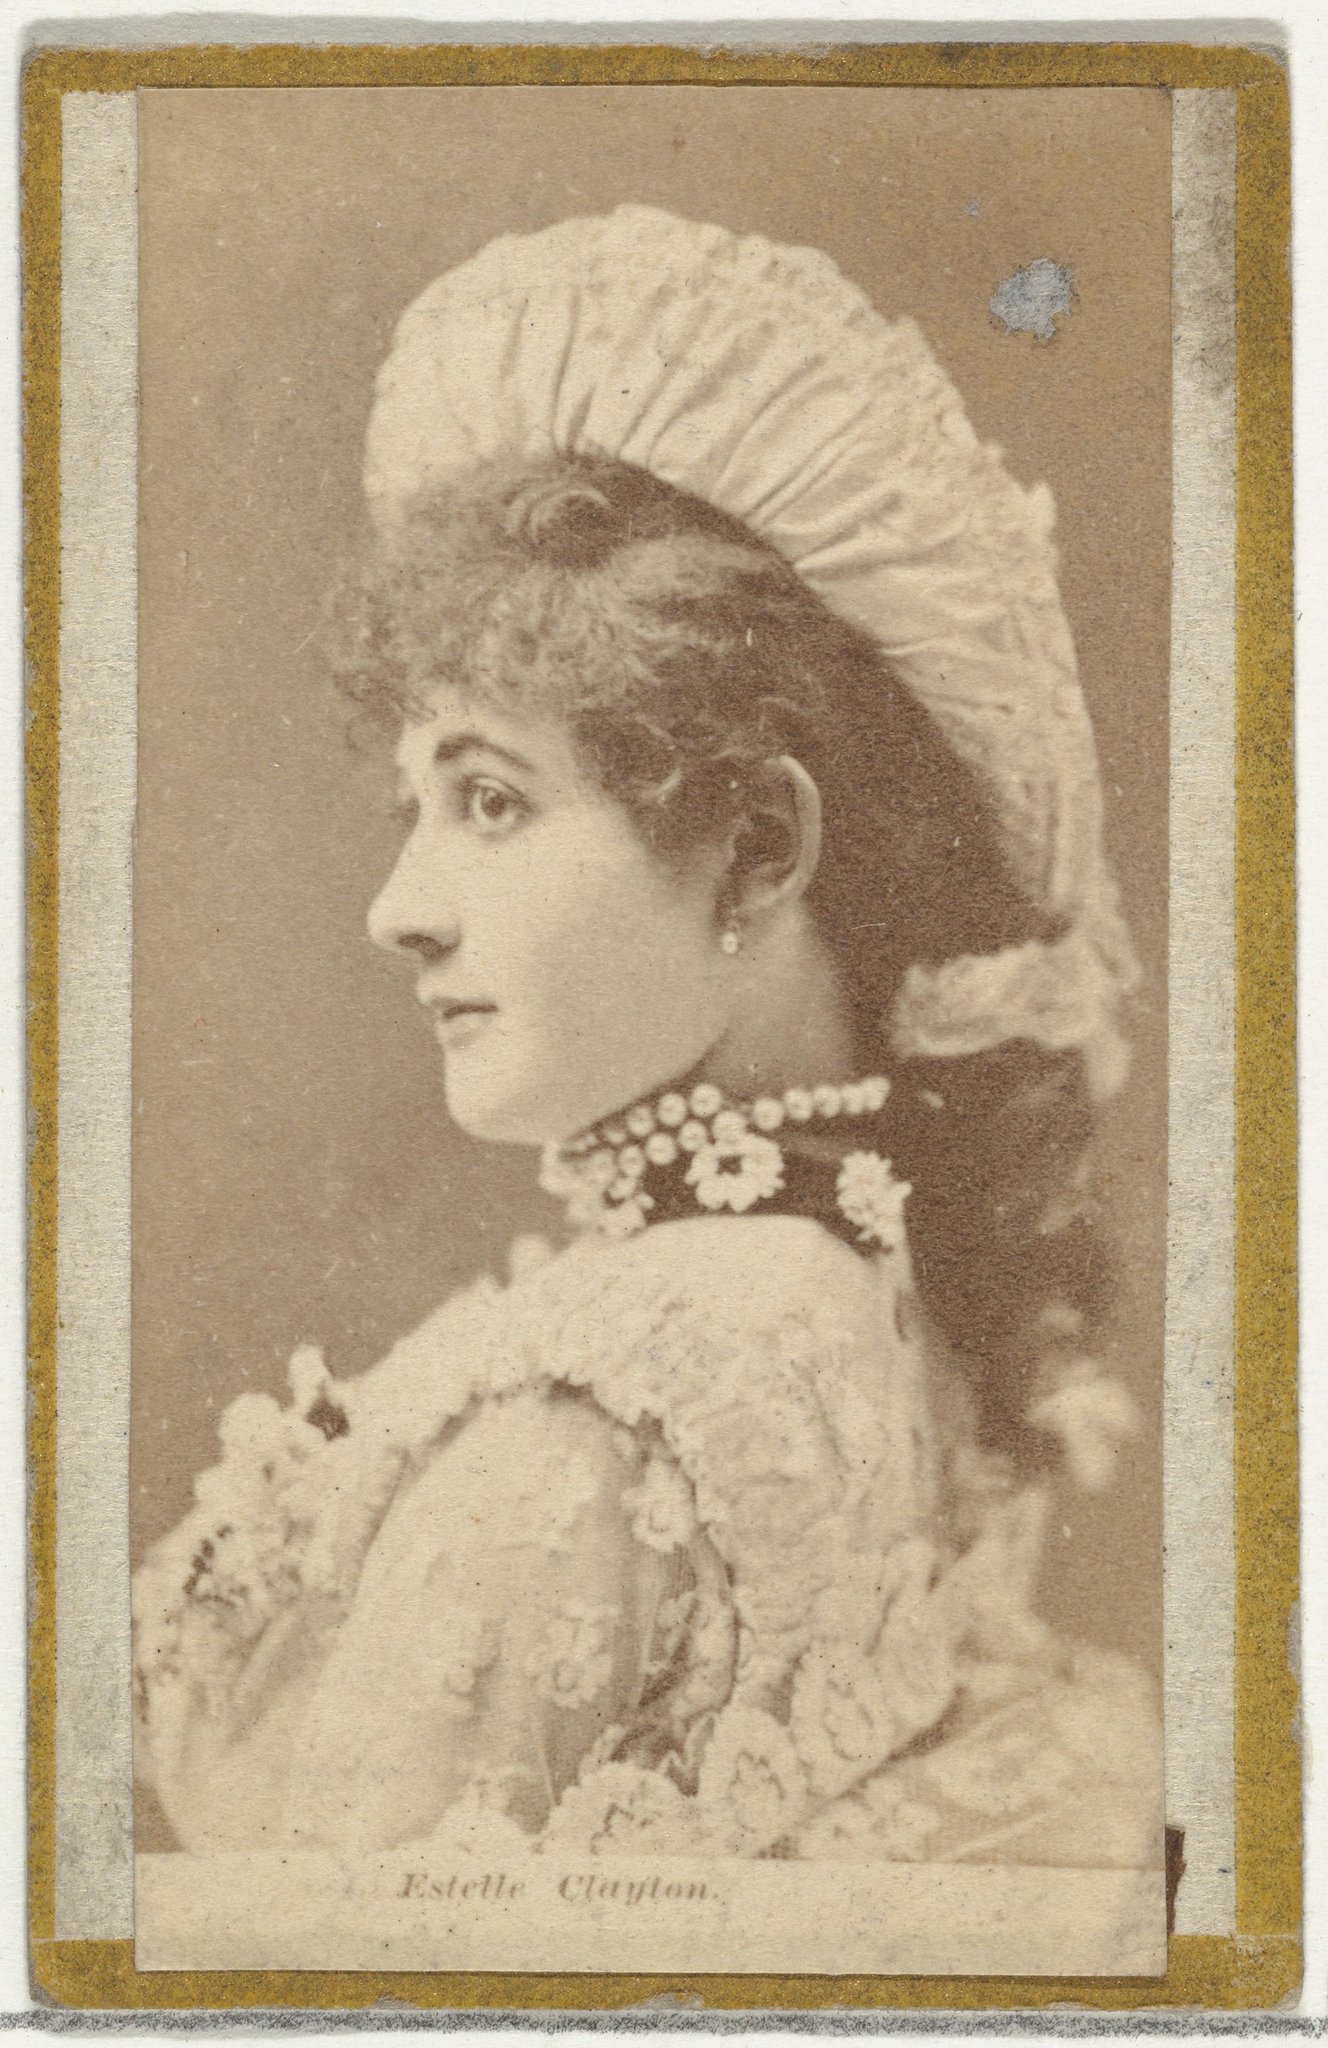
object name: photograph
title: Estelle Clayton, from the Actresses and Celebrities series (N60, Type 2) promoting Little Beauties Cigarettes for Allen & Ginter brand tobacco products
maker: allen & ginter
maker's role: publisher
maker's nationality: american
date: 1887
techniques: albumen silver print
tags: portraits,profiles,women,actresses